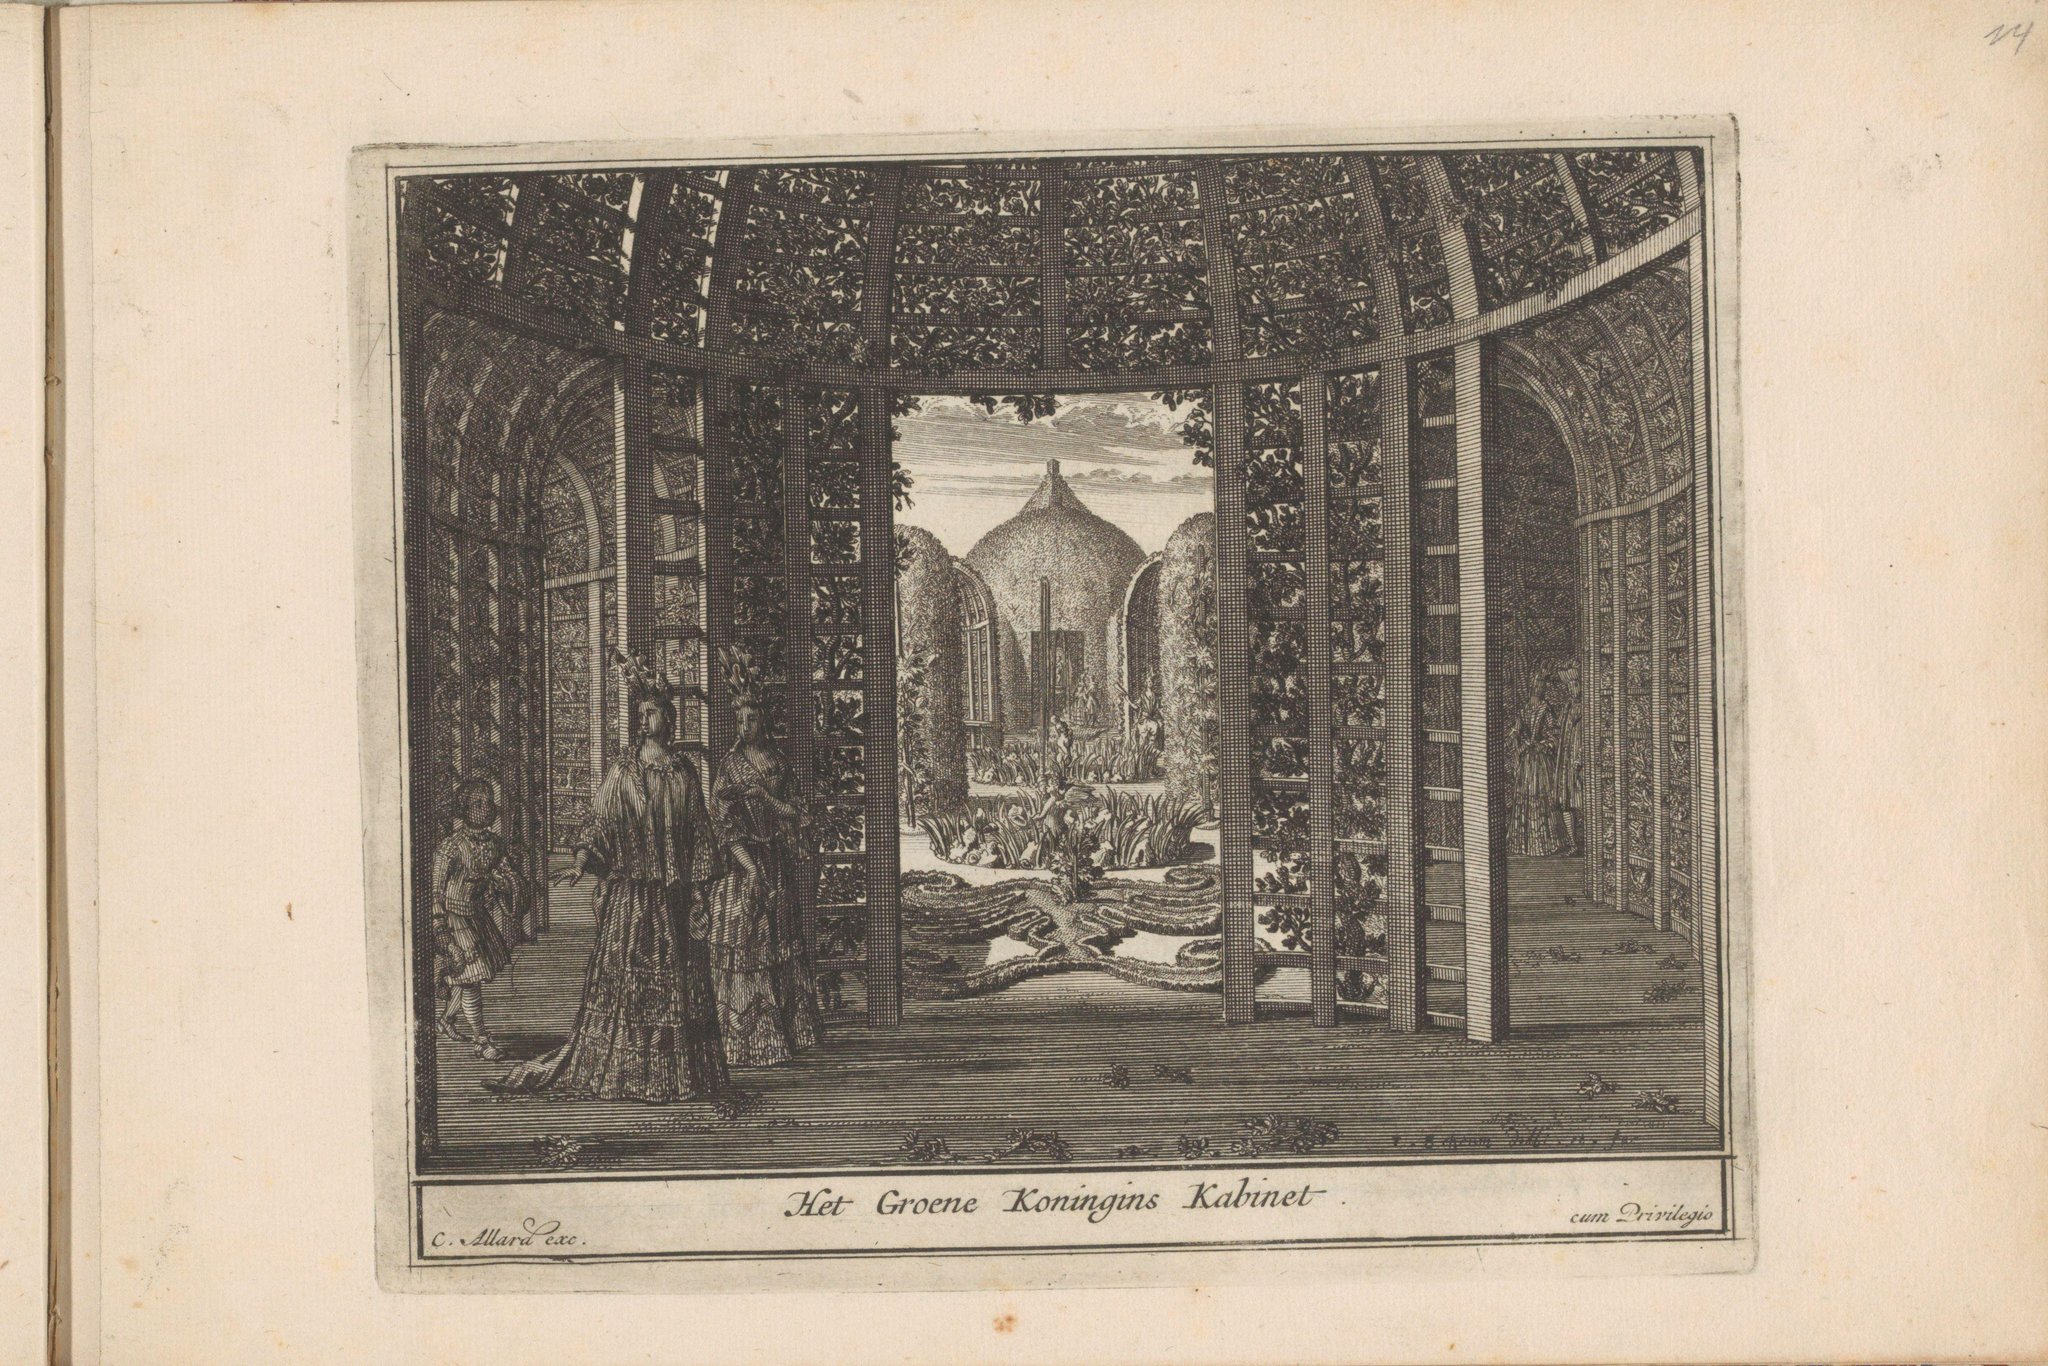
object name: album leaf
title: Berceaus in de tuinen van Paleis Het Loo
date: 1689-1701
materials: paper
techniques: etching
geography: amsterdam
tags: french or architectonic garden; formal garden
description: Zicht in de Koninginnetuin bij Paleis Het Loo met links en rechts berceaus. Prent maakt deel uit van een album.